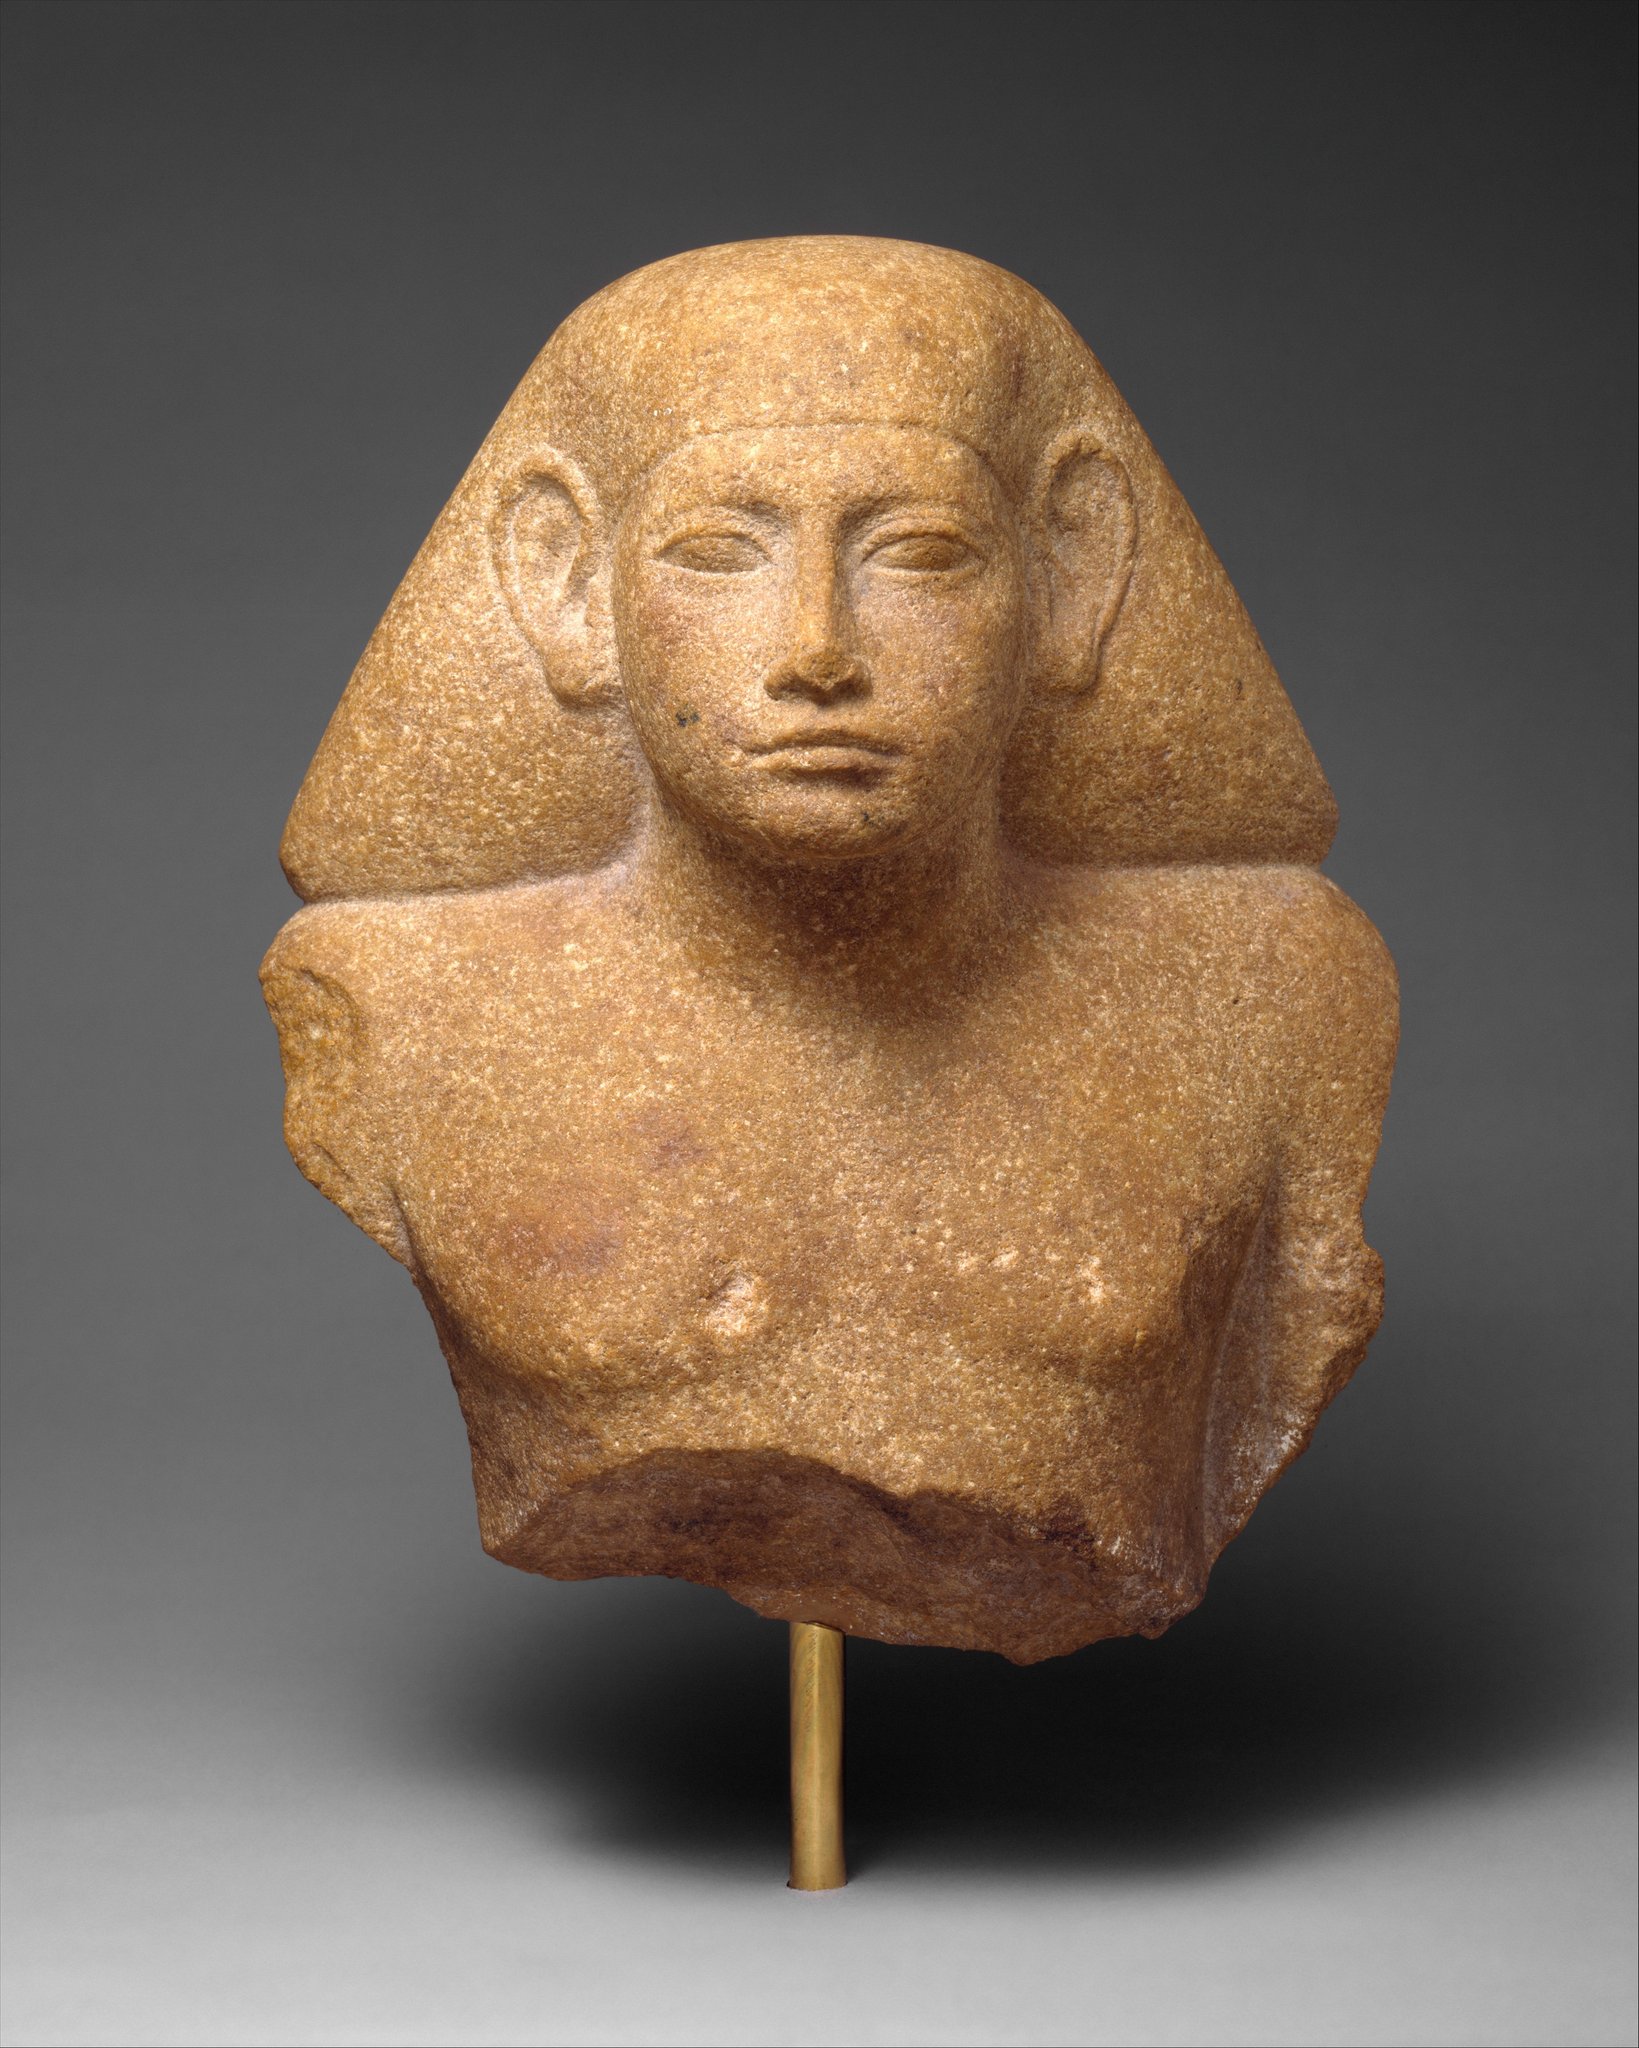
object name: upper part of a statue, scribal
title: Upper Part of a Statue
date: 1859-1750 BCE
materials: quartzite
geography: egypt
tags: men